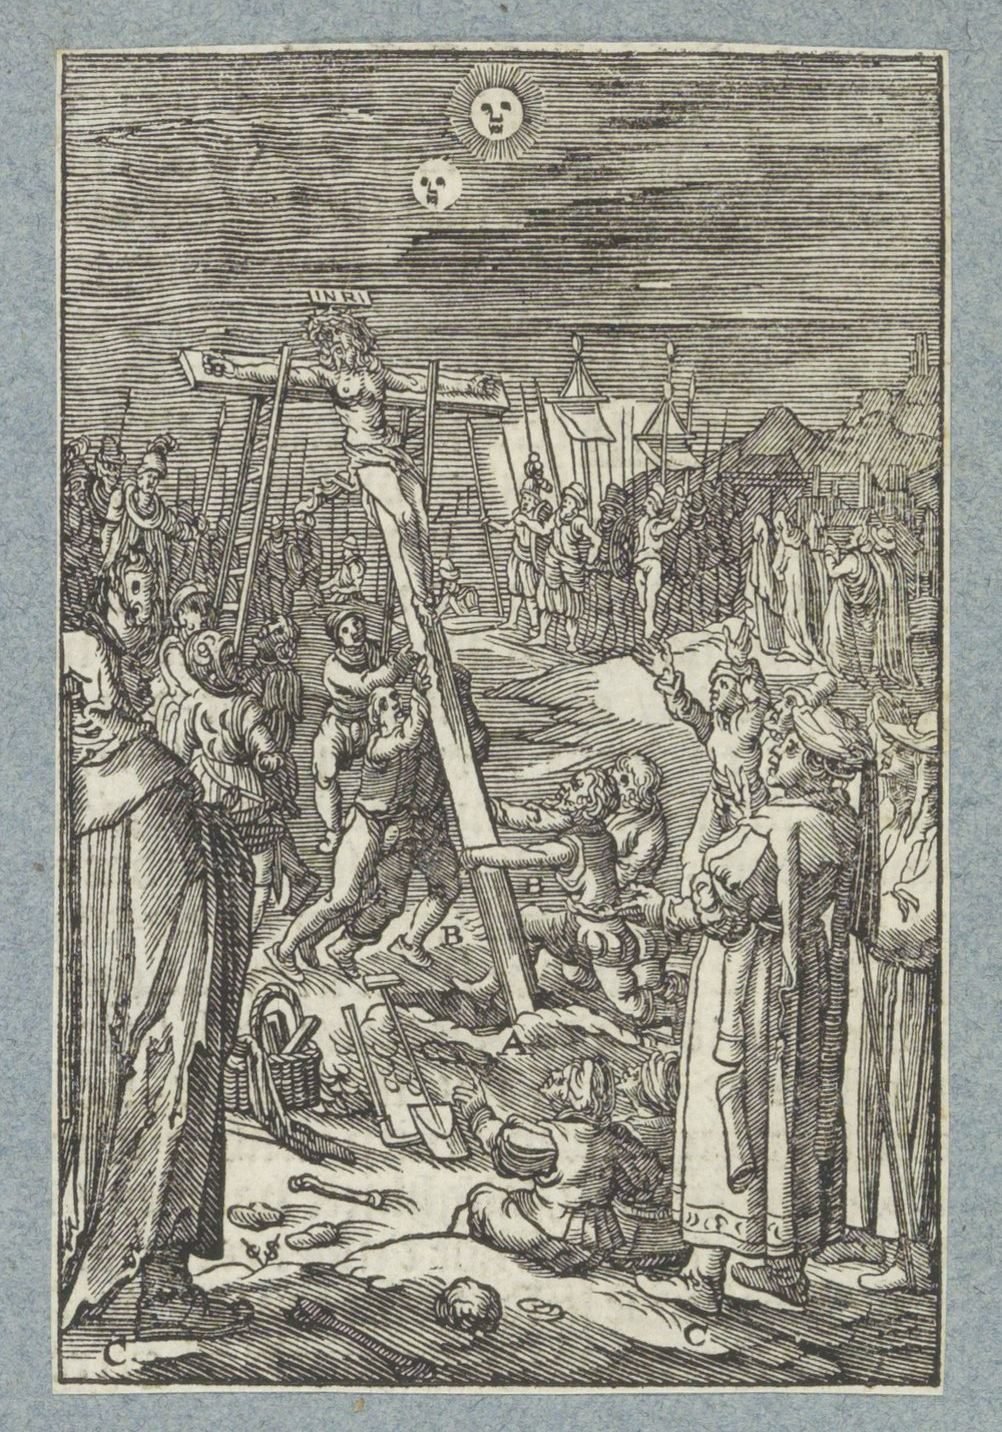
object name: album leaf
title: Kruisoprichting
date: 1629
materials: paper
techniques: letterpress printing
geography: amsterdam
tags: the erection of the cross: raising of the cross (without christ)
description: De prent is afkomstig uit een van de uitgaven van P.J. Paets uit Amsterdam. De prent wordt voor het eerst gebruikt in: Der Zielen Lust-hof. Leuven, I.Jacbosz voor P.J. Paets [= Amsterdam, P.J. Paets], 1629. De voorstelling is gekopieerd naar een prent van Hieronymus Wierix voor: Nadal, Jerónimo. Evangelicae Historiae Imagines. Antwerpen, M. Nutius, 1593.